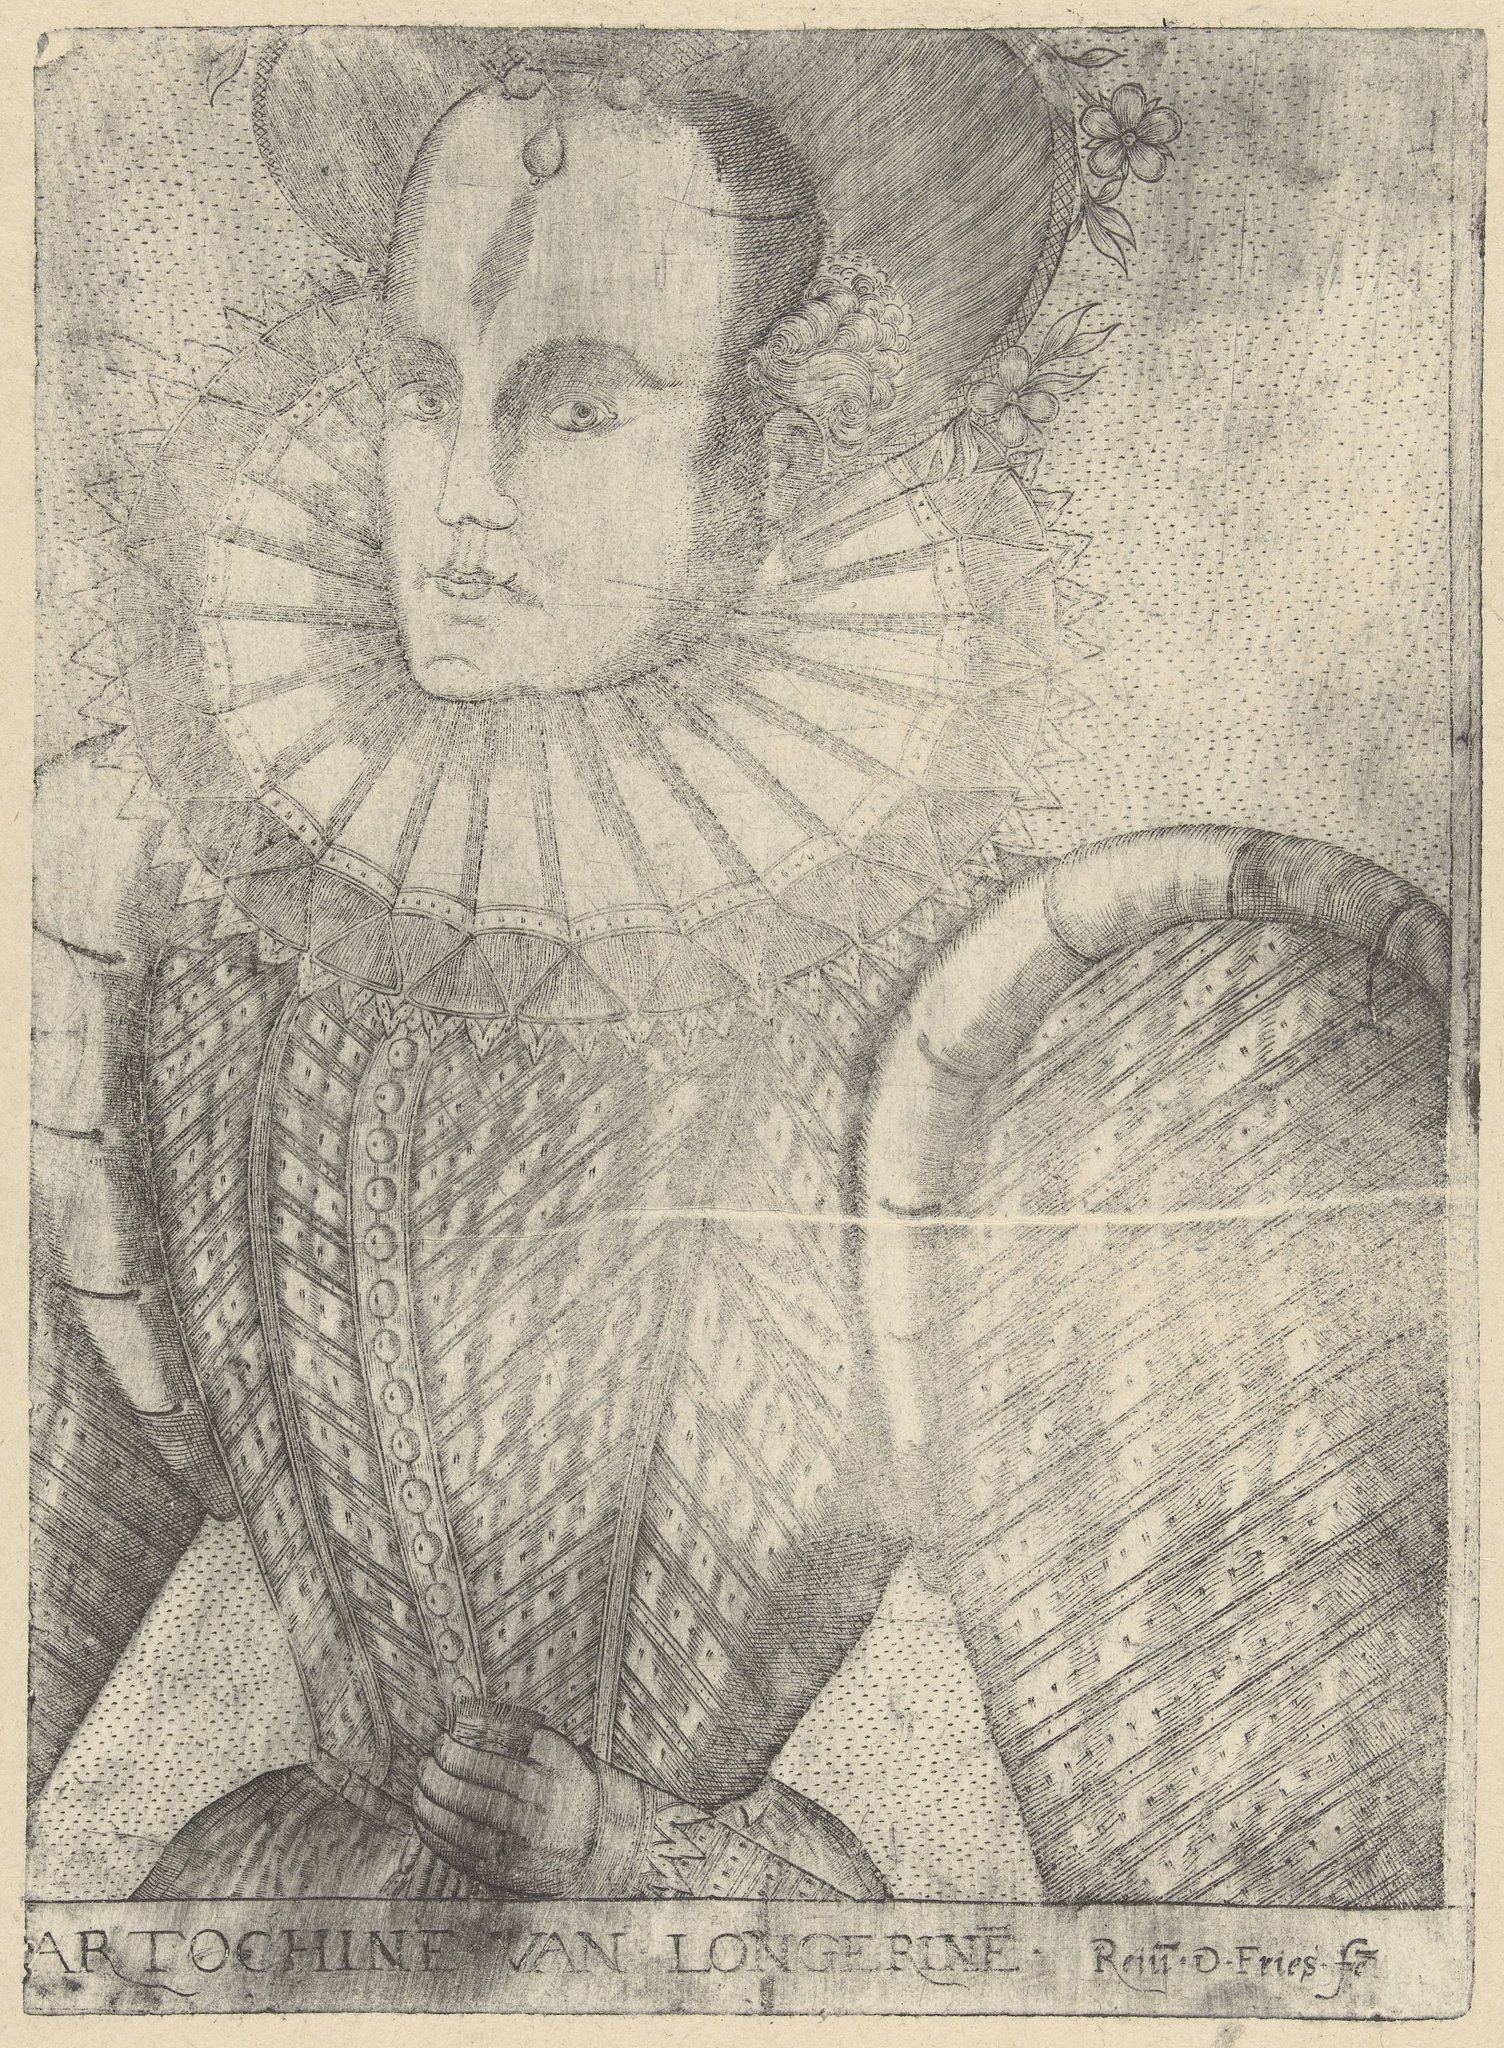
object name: print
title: Hertogin van Longerine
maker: reinier de fries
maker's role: print maker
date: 1900-1999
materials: paper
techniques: engraving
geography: northern netherlands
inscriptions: collector's mark: ‘Staatl. kunstsammlungen Weimar’, inscription: ‘neudruck L.534/50’